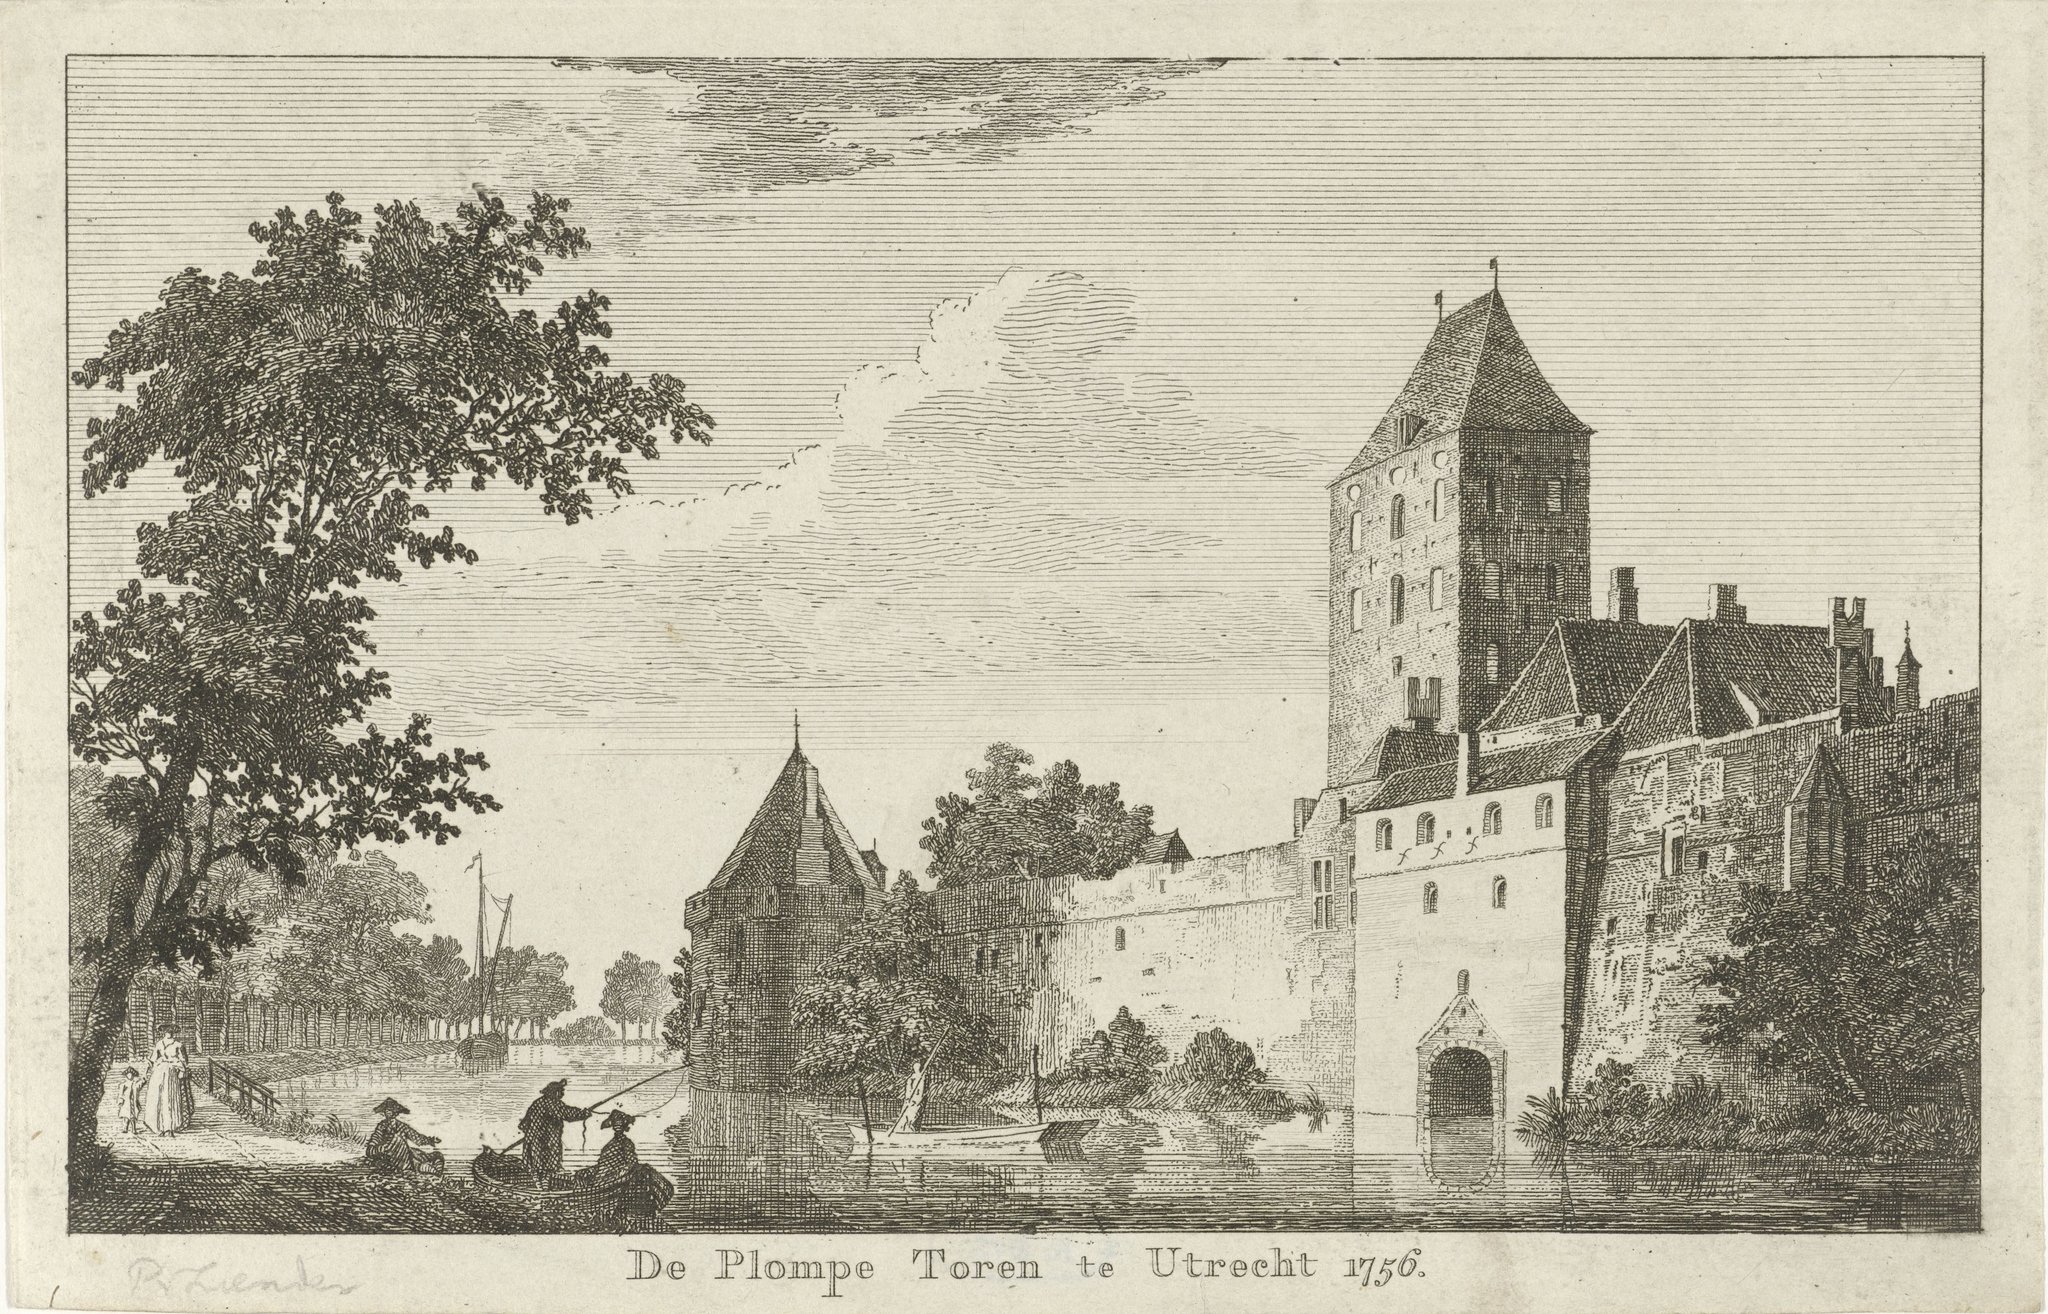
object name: print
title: Twee paarden in een doorgang van een vervallen gebouw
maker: friedrich august de leuw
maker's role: print maker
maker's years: 1817-1888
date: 1842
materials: paper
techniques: etching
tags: horse, ruin of a dwelling, house, castle, etc.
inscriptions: collector's mark: Lugt 2228